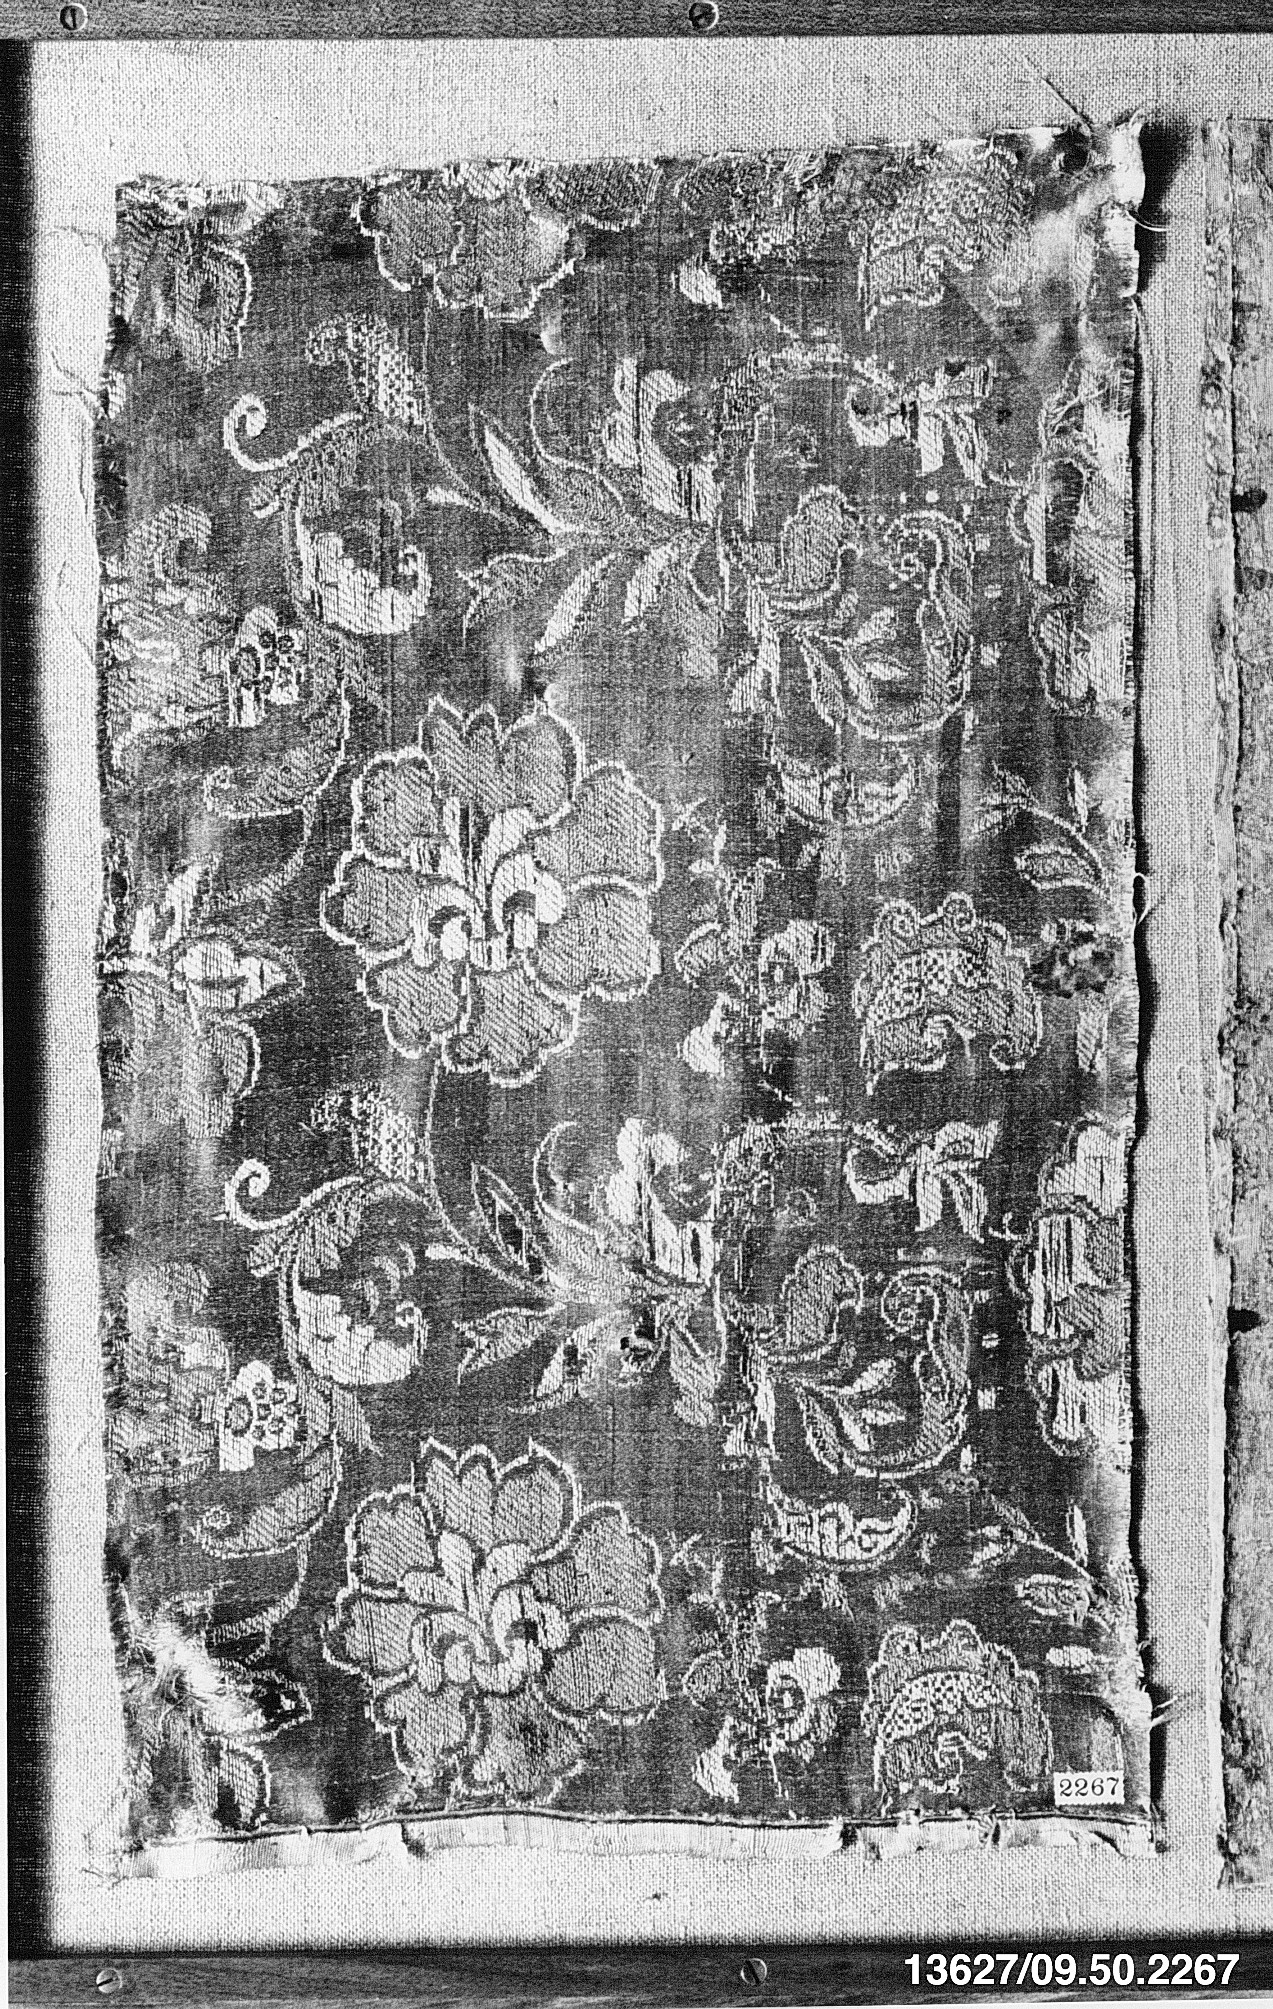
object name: piece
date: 1701-1733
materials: silk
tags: flowers,leaves